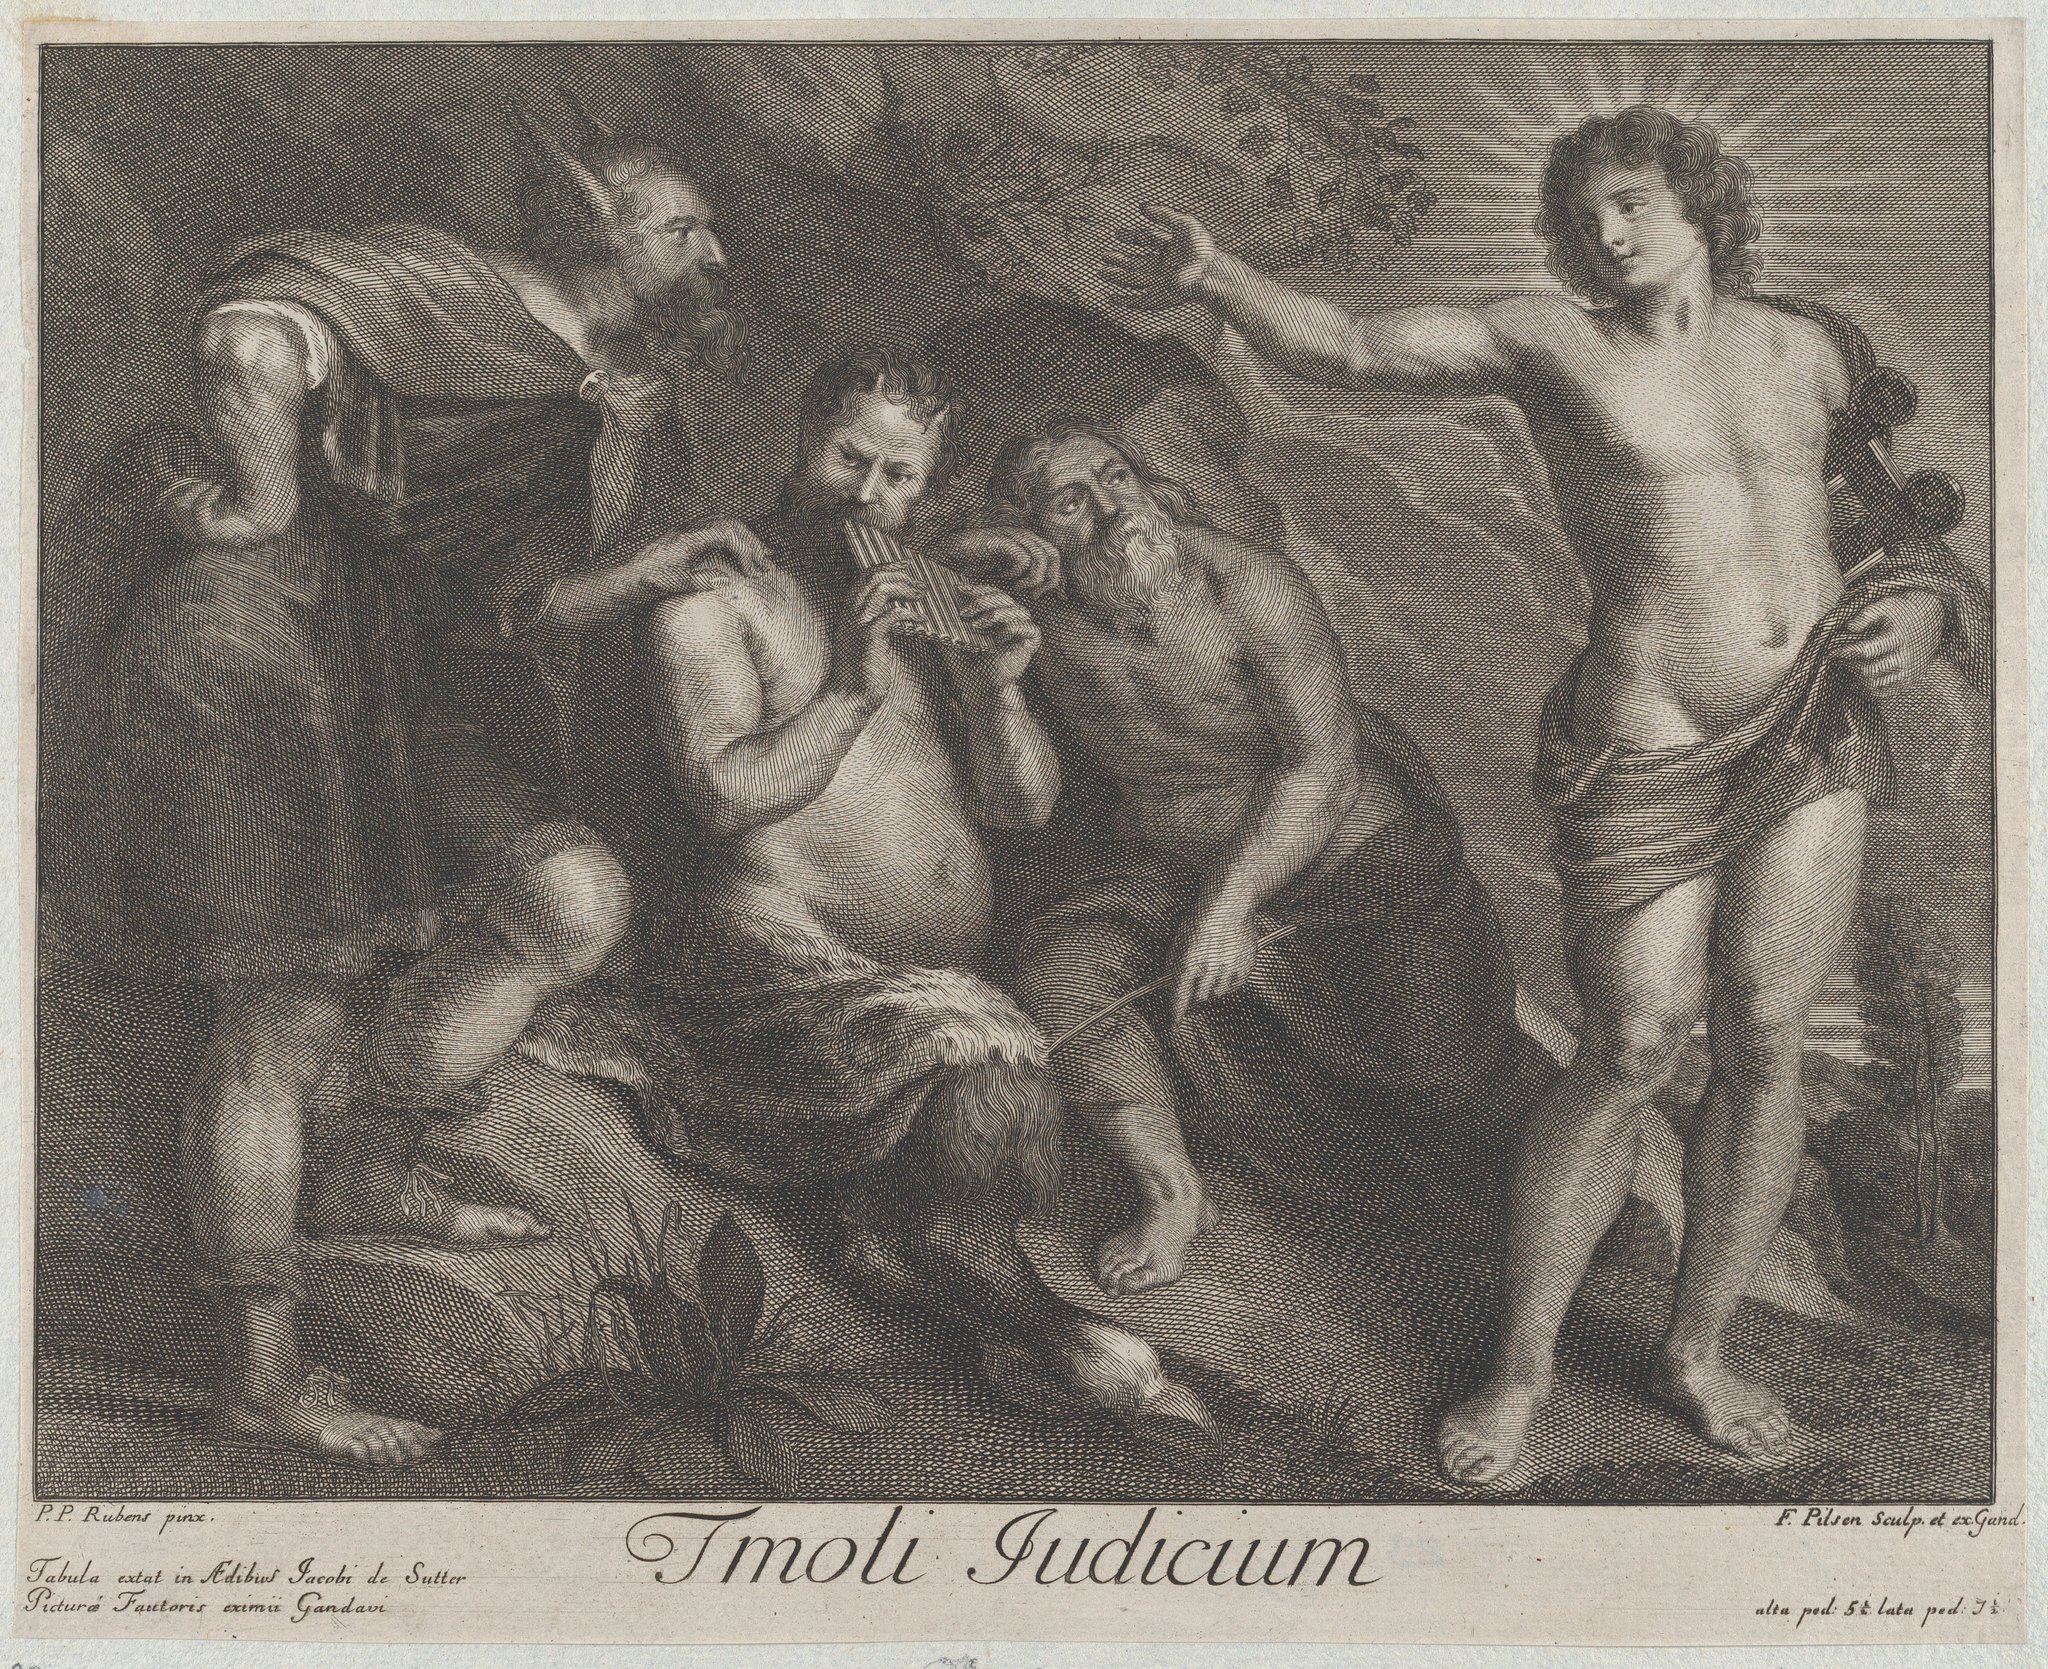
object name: print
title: The Judgment of Midas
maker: frans pilsen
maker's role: print maker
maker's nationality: flemish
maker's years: 1700-1784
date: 1734-1777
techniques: engraving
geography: ghent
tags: men,midas,fauns